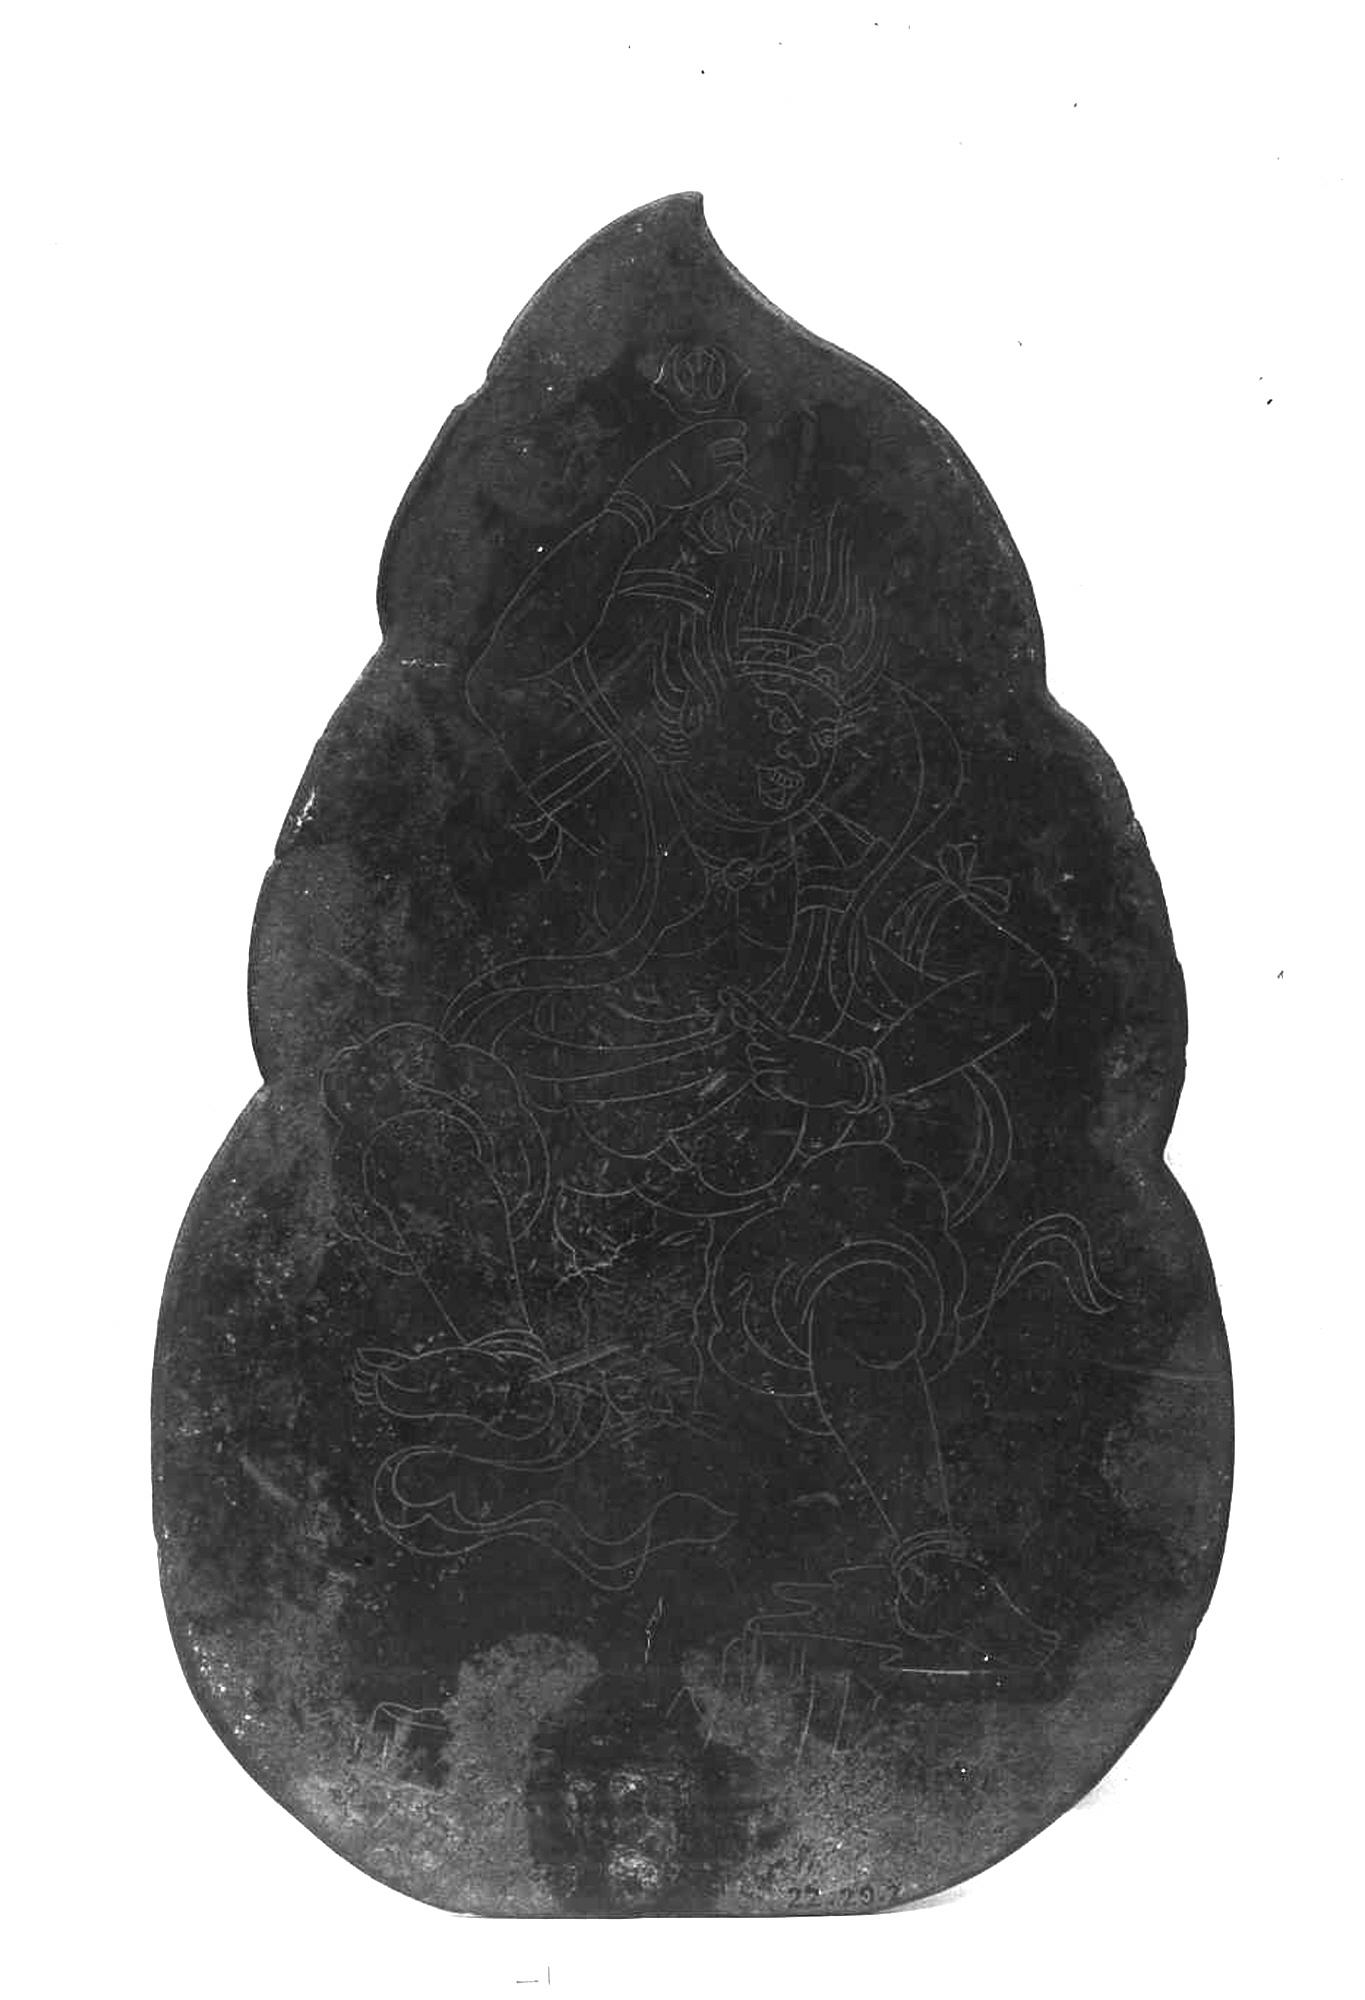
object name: plaque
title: Votive plaque of Zaō Gongen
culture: japanese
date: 1001-1100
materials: bronze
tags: men